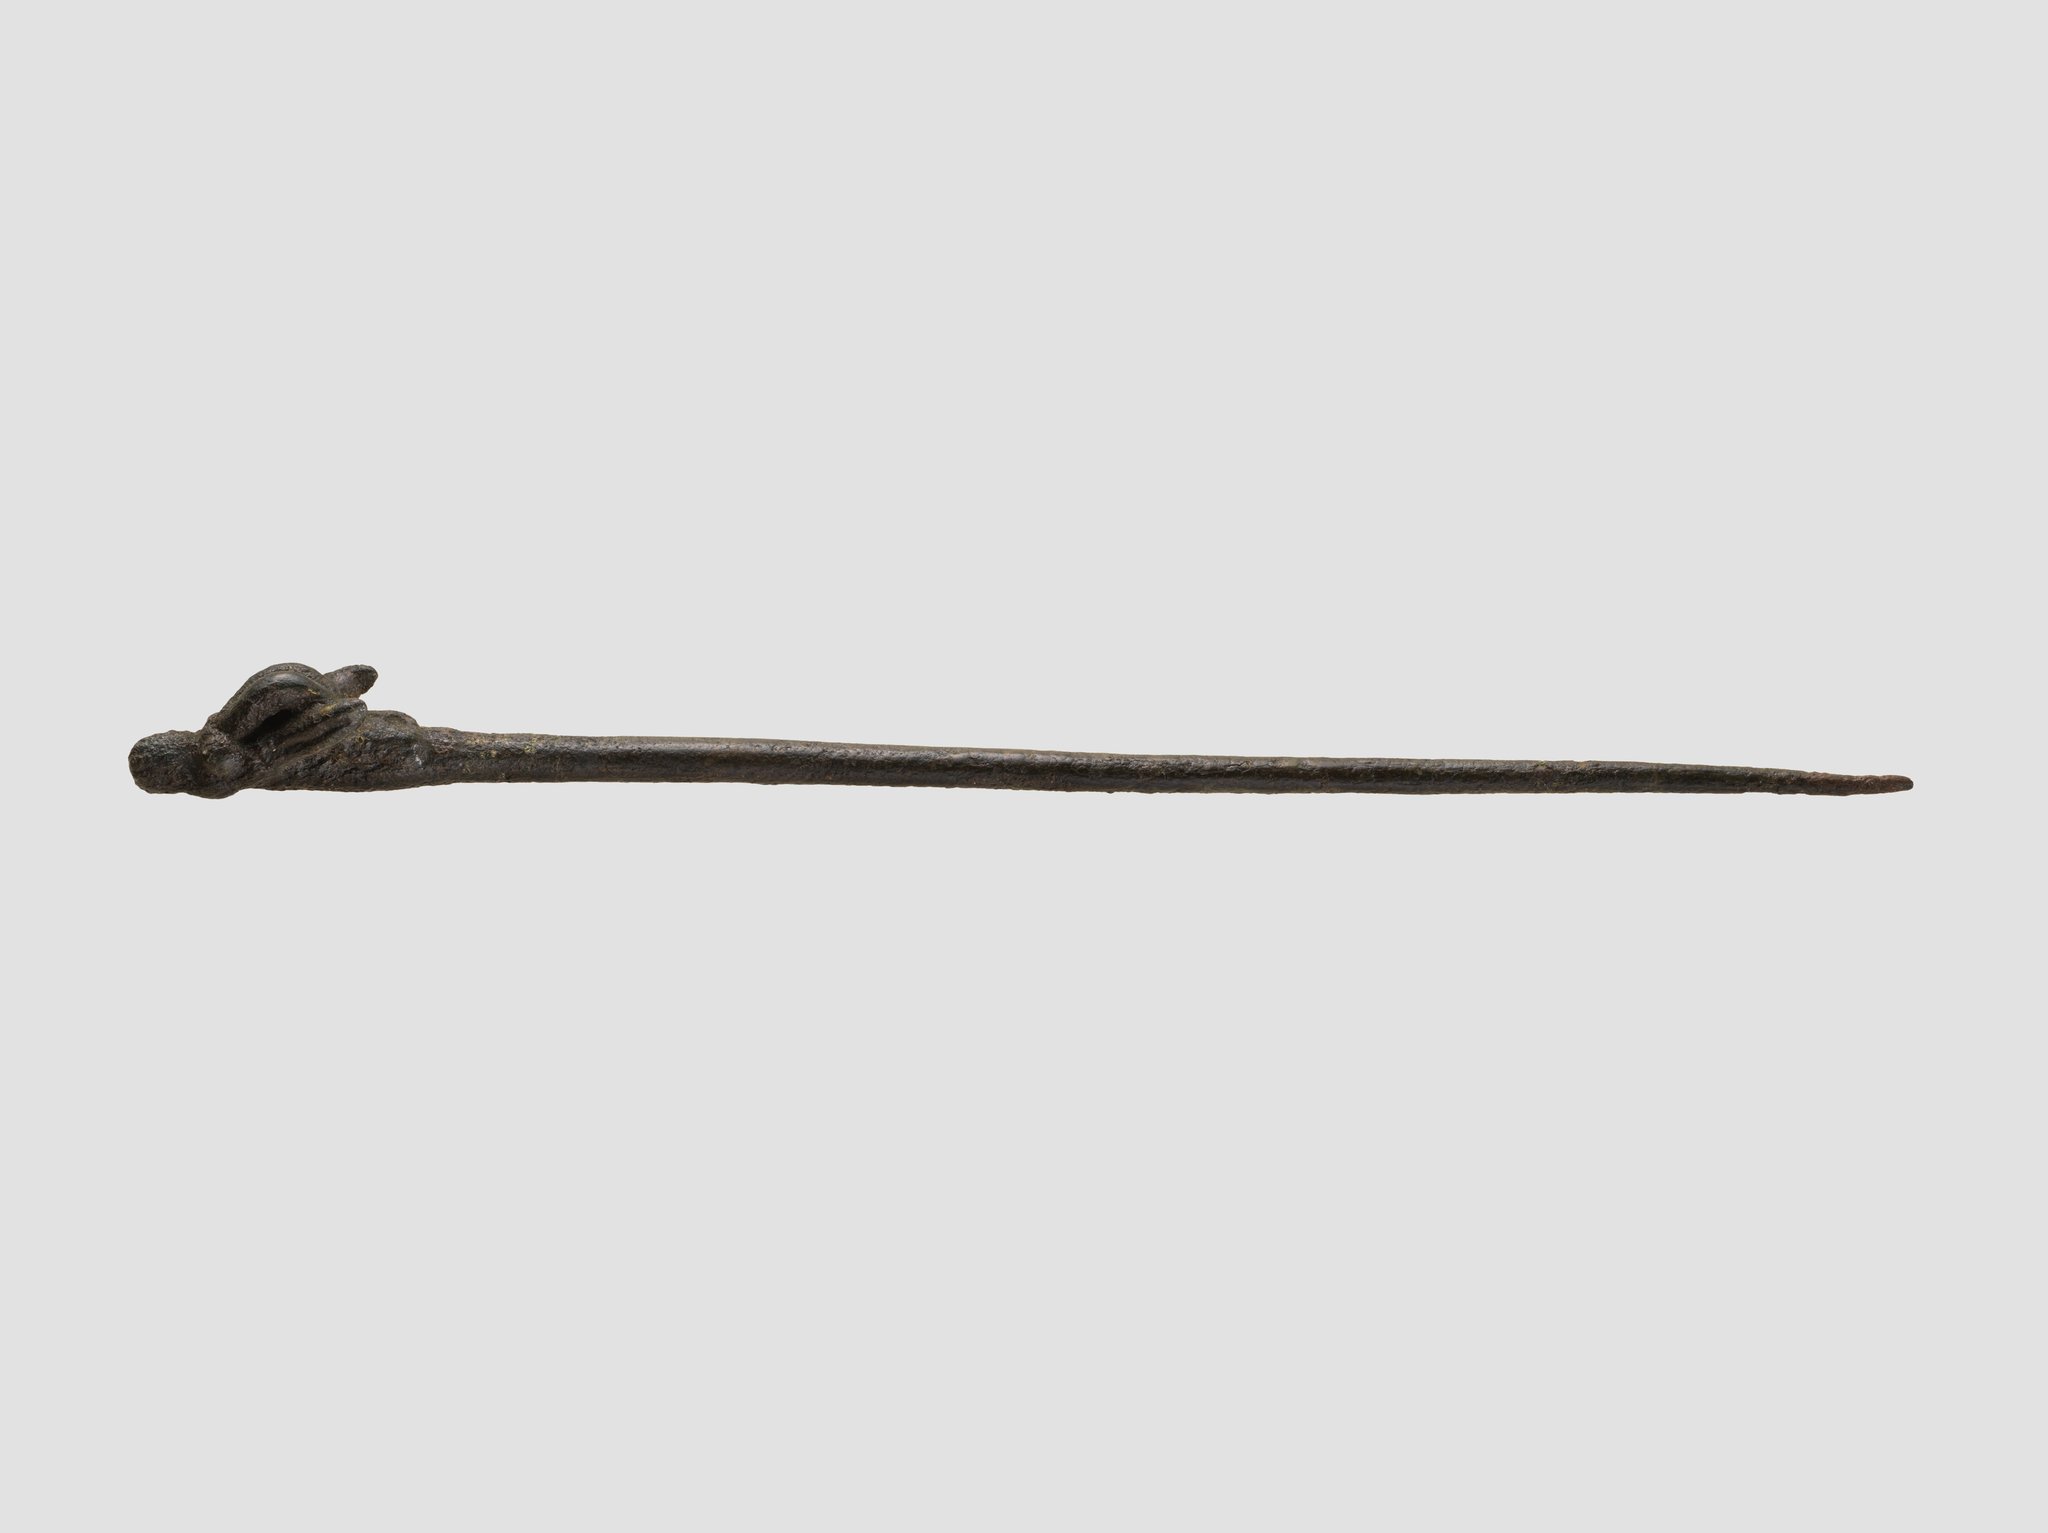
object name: pin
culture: iranian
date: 800-601 BCE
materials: bronze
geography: iran, luristan